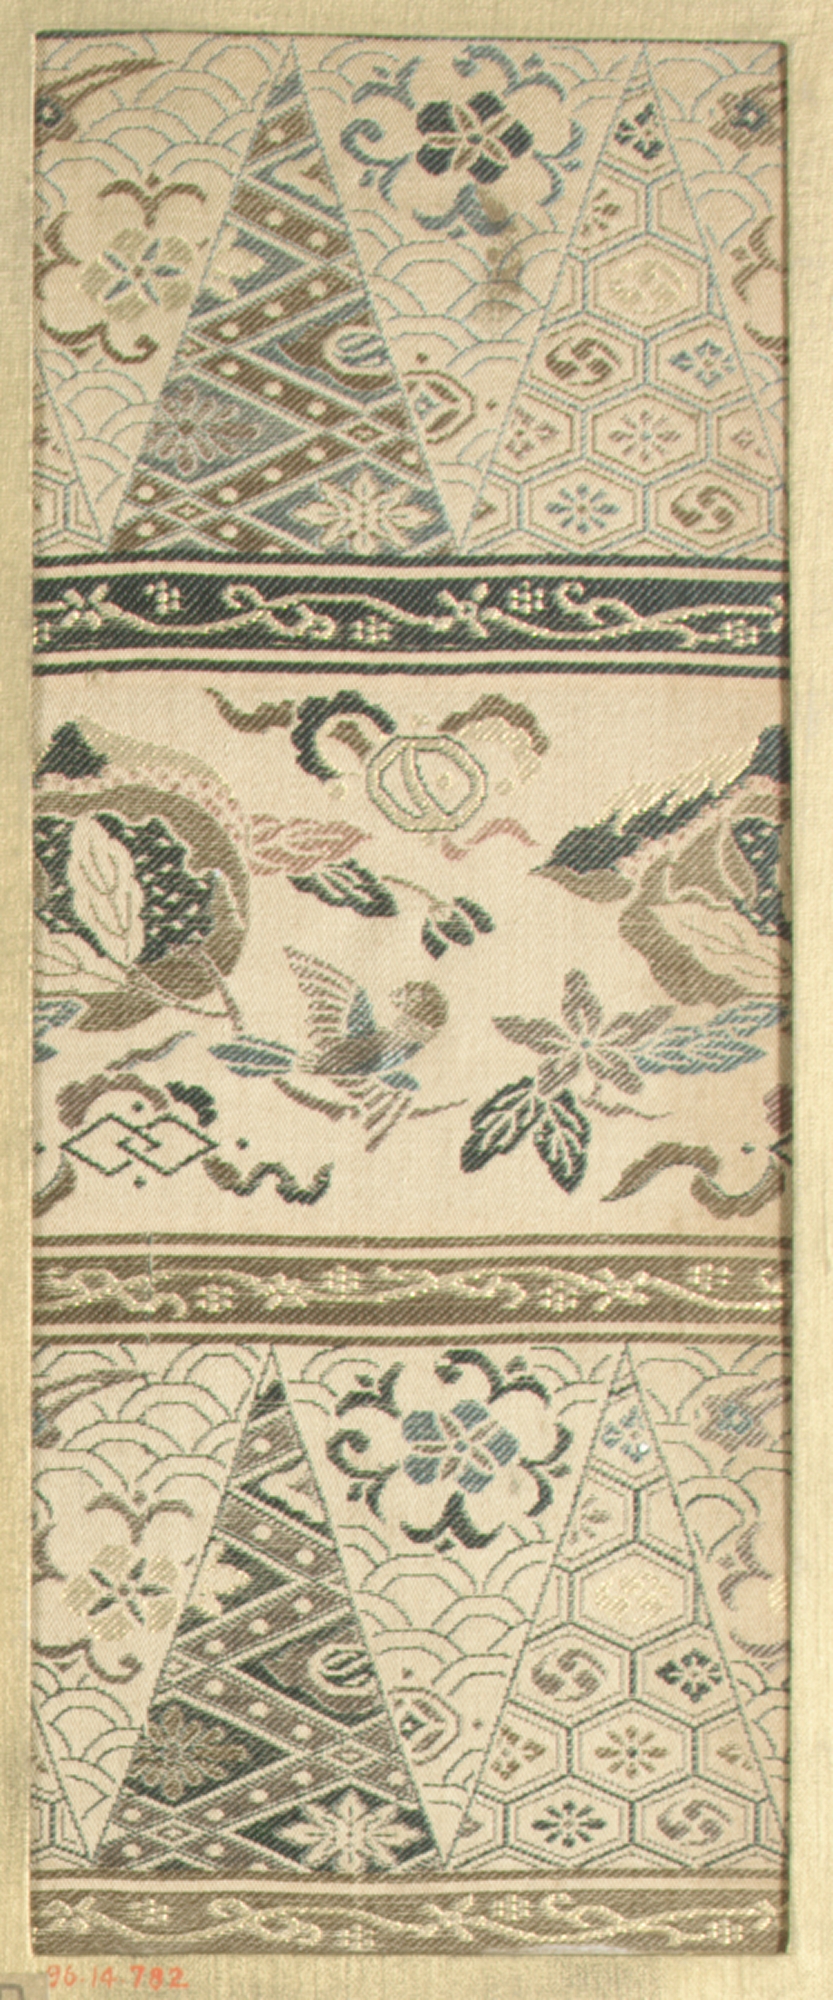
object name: piece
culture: japanese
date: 1701-1900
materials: silk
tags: birds